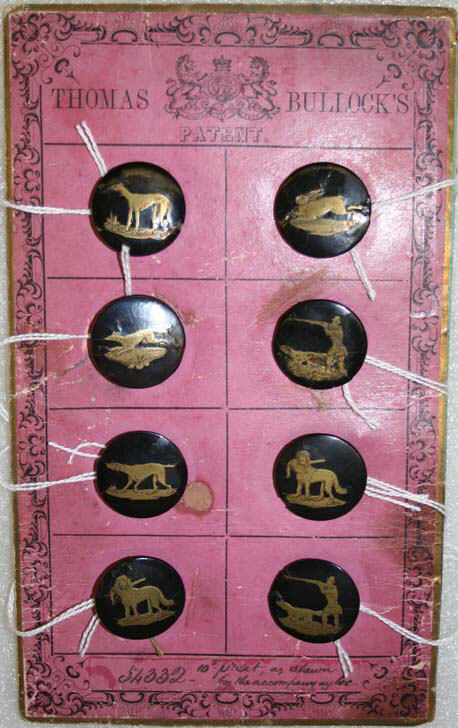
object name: button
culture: british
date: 1840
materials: horn, metal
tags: men,hunting,dogs,rabbits